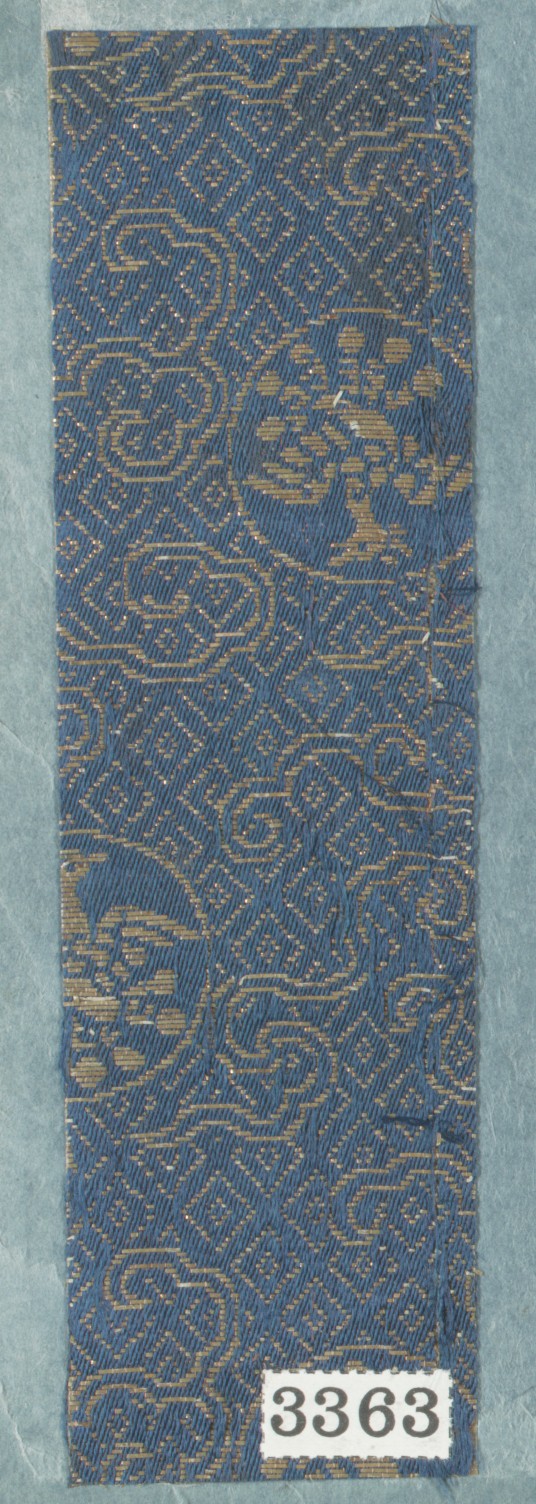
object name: textile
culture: japanese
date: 1801-1900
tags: birds